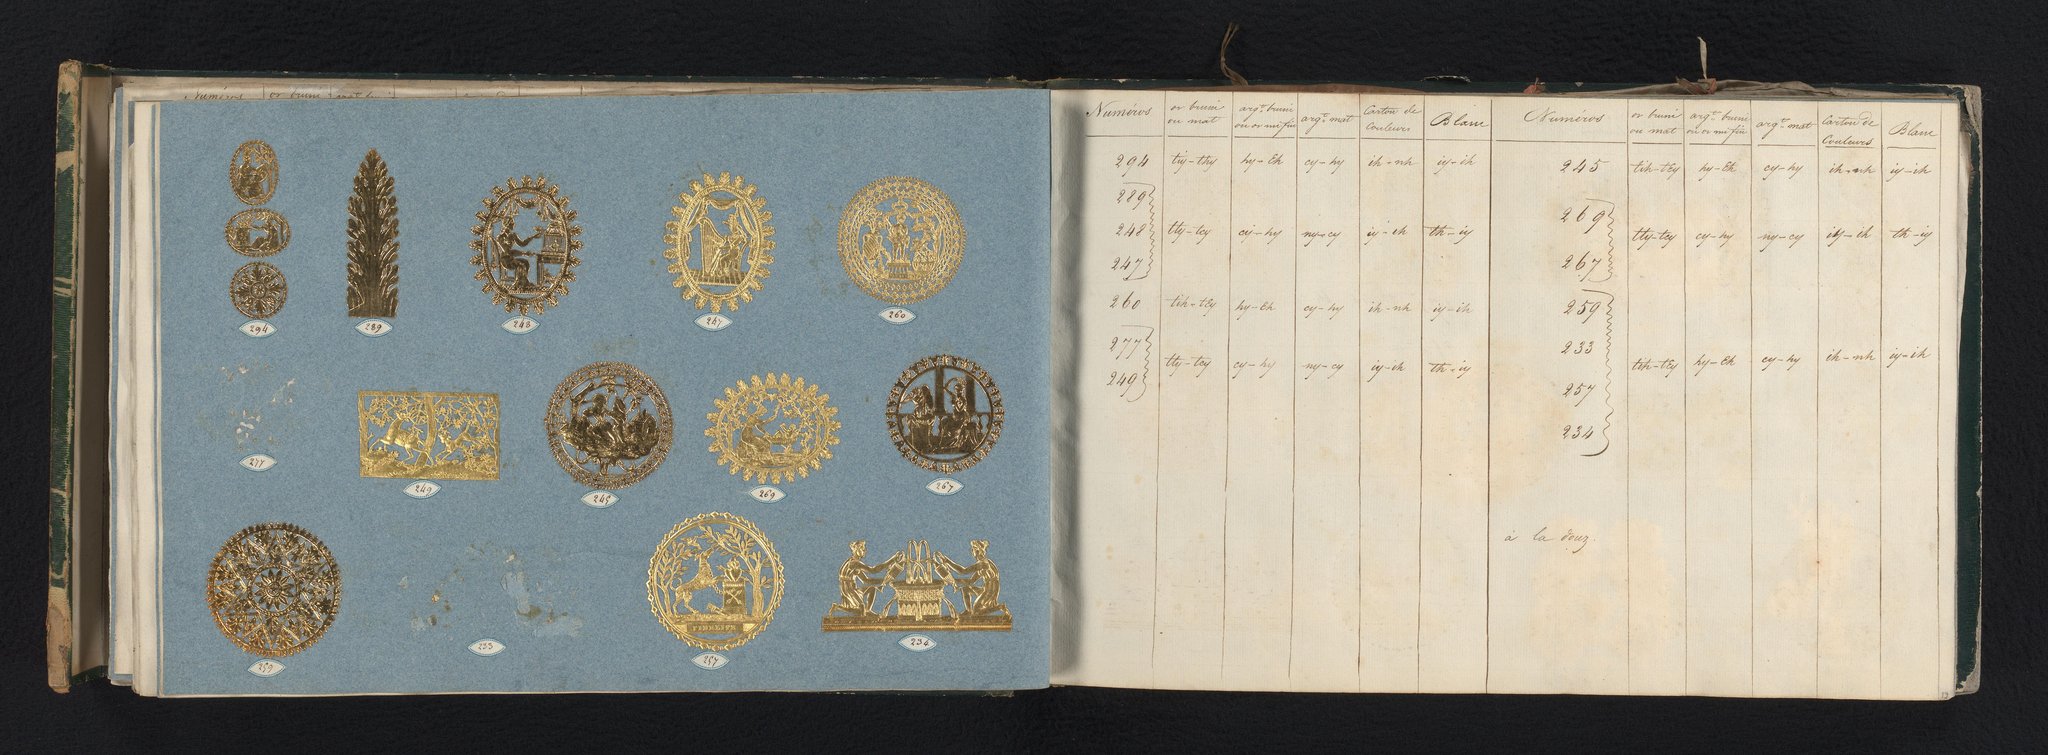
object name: metallic paper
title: Twee bladzijden met stalen van vignetten van goudkleurig metaalpapier en bijbehorend tabel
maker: Anonymous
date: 1830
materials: gold leaf, ink, paper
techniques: manufacturing, writing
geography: france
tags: ornaments ~ art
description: Twee bladzijden met links 12 opgeplakte en met etiketten genummerde (294-234) stalen van afzonderlijke vignetten en emblemen van goudkleurig metaalpapier (stalen nrs. 277 en 233 ontbreken). Op de tegenoverliggende rechterbladzijde een tabel met de handgeschreven corresponderende specificaties (in code) per ornament. Onderdeel van het stalenboek geschonken door de dames Van Rijn, vermoedelijk van een Franse papierfabrikant van luxe papieren, of diens vertegenwoordiger in Nederland, ca. 1830.